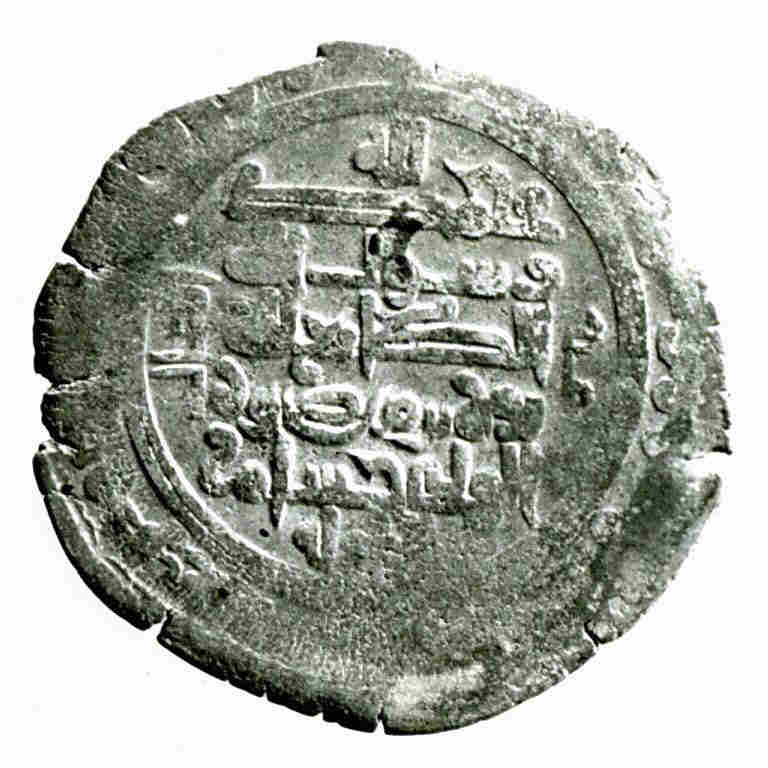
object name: coin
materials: silver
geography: iran